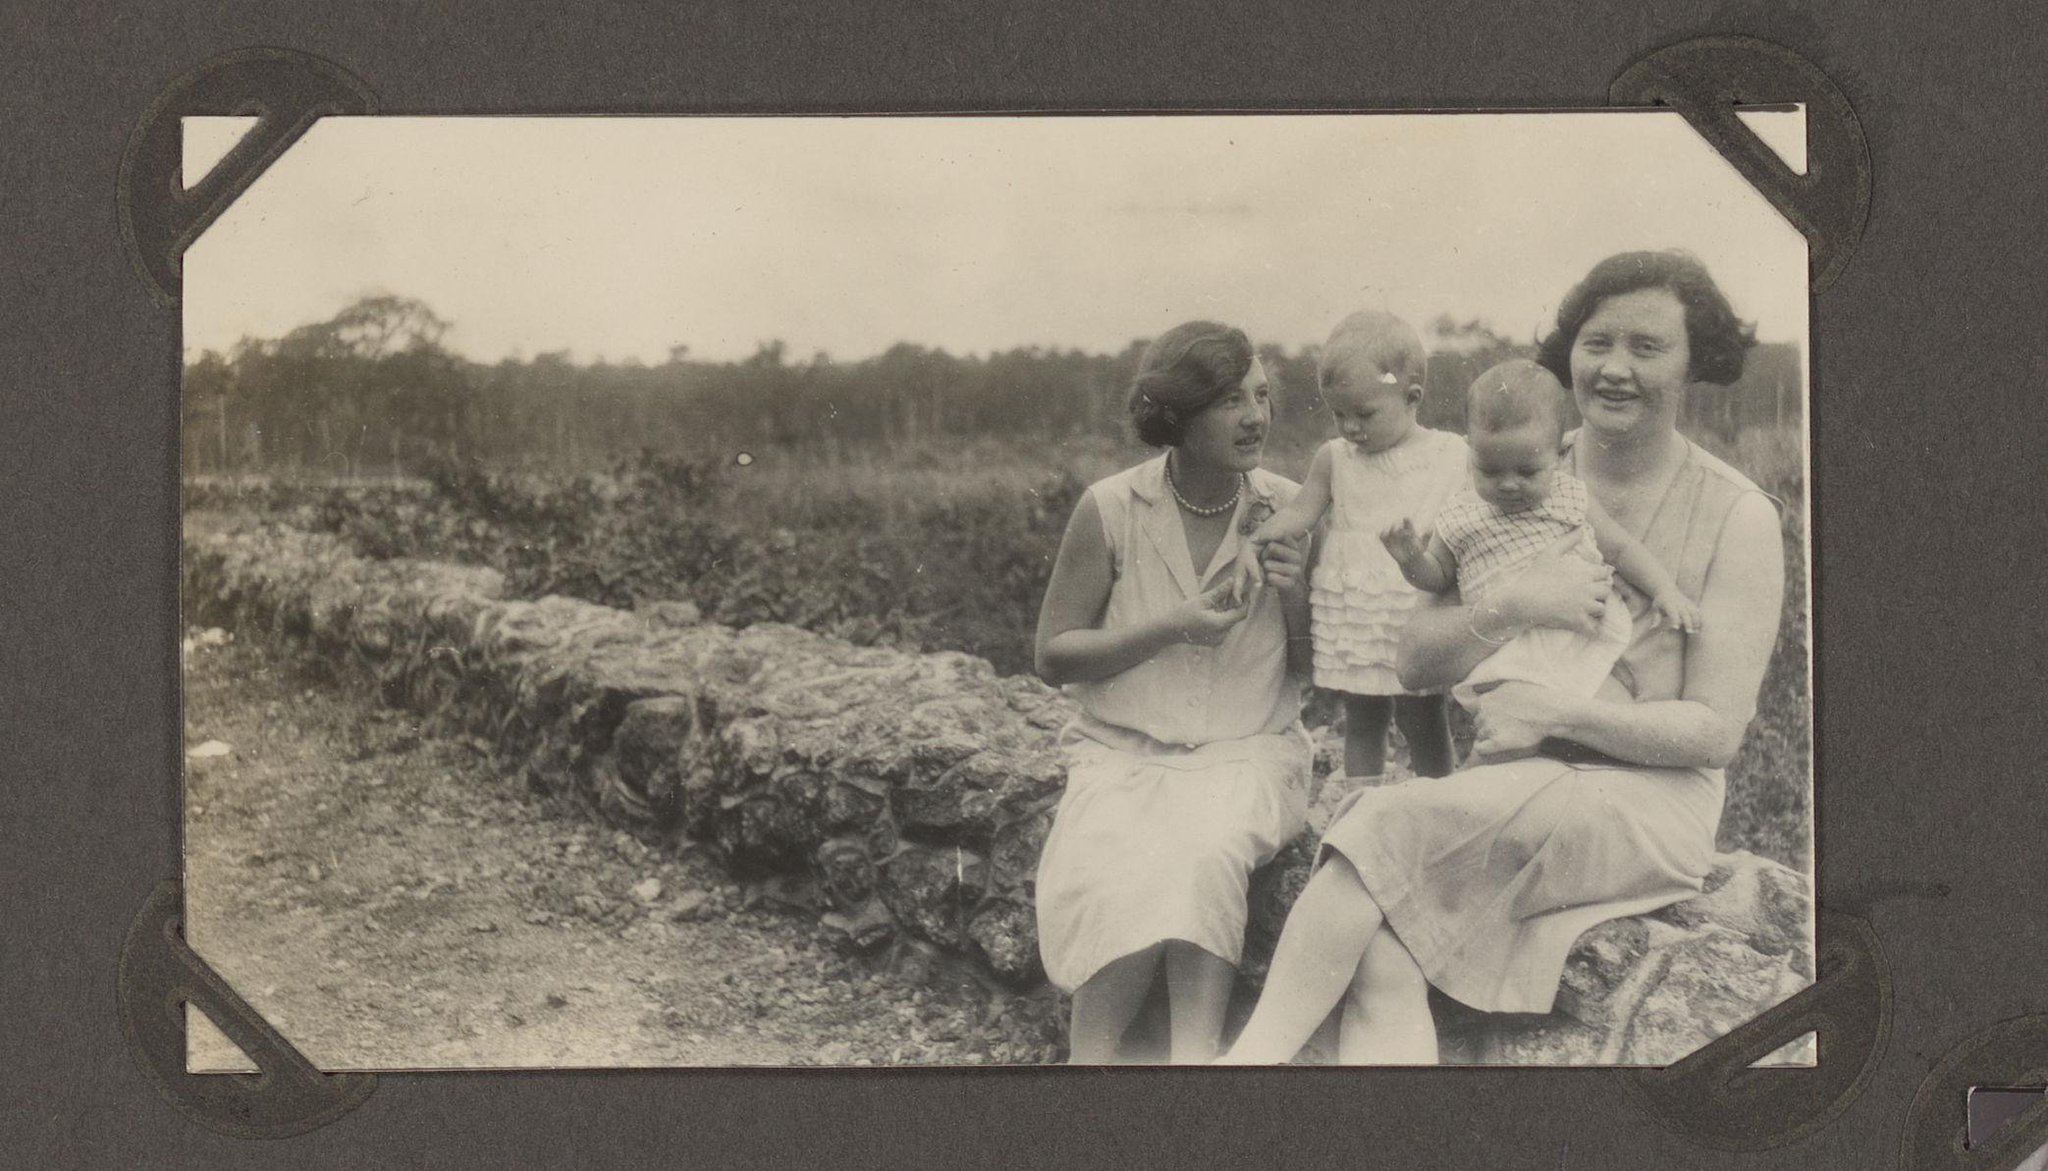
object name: photograph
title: Familiefoto van de kinderen Jetten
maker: Anonymous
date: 1925-1927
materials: photographic support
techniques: photography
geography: suriname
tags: jetten, familie, moengo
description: Familiefoto van de kinderen Jetten. Foto op een bladzijde van een los albumblad. Onderdeel van het ensemble met foto's van de familie van ingenieur Jetten in de mijnbouwstad Moengo in Suriname.